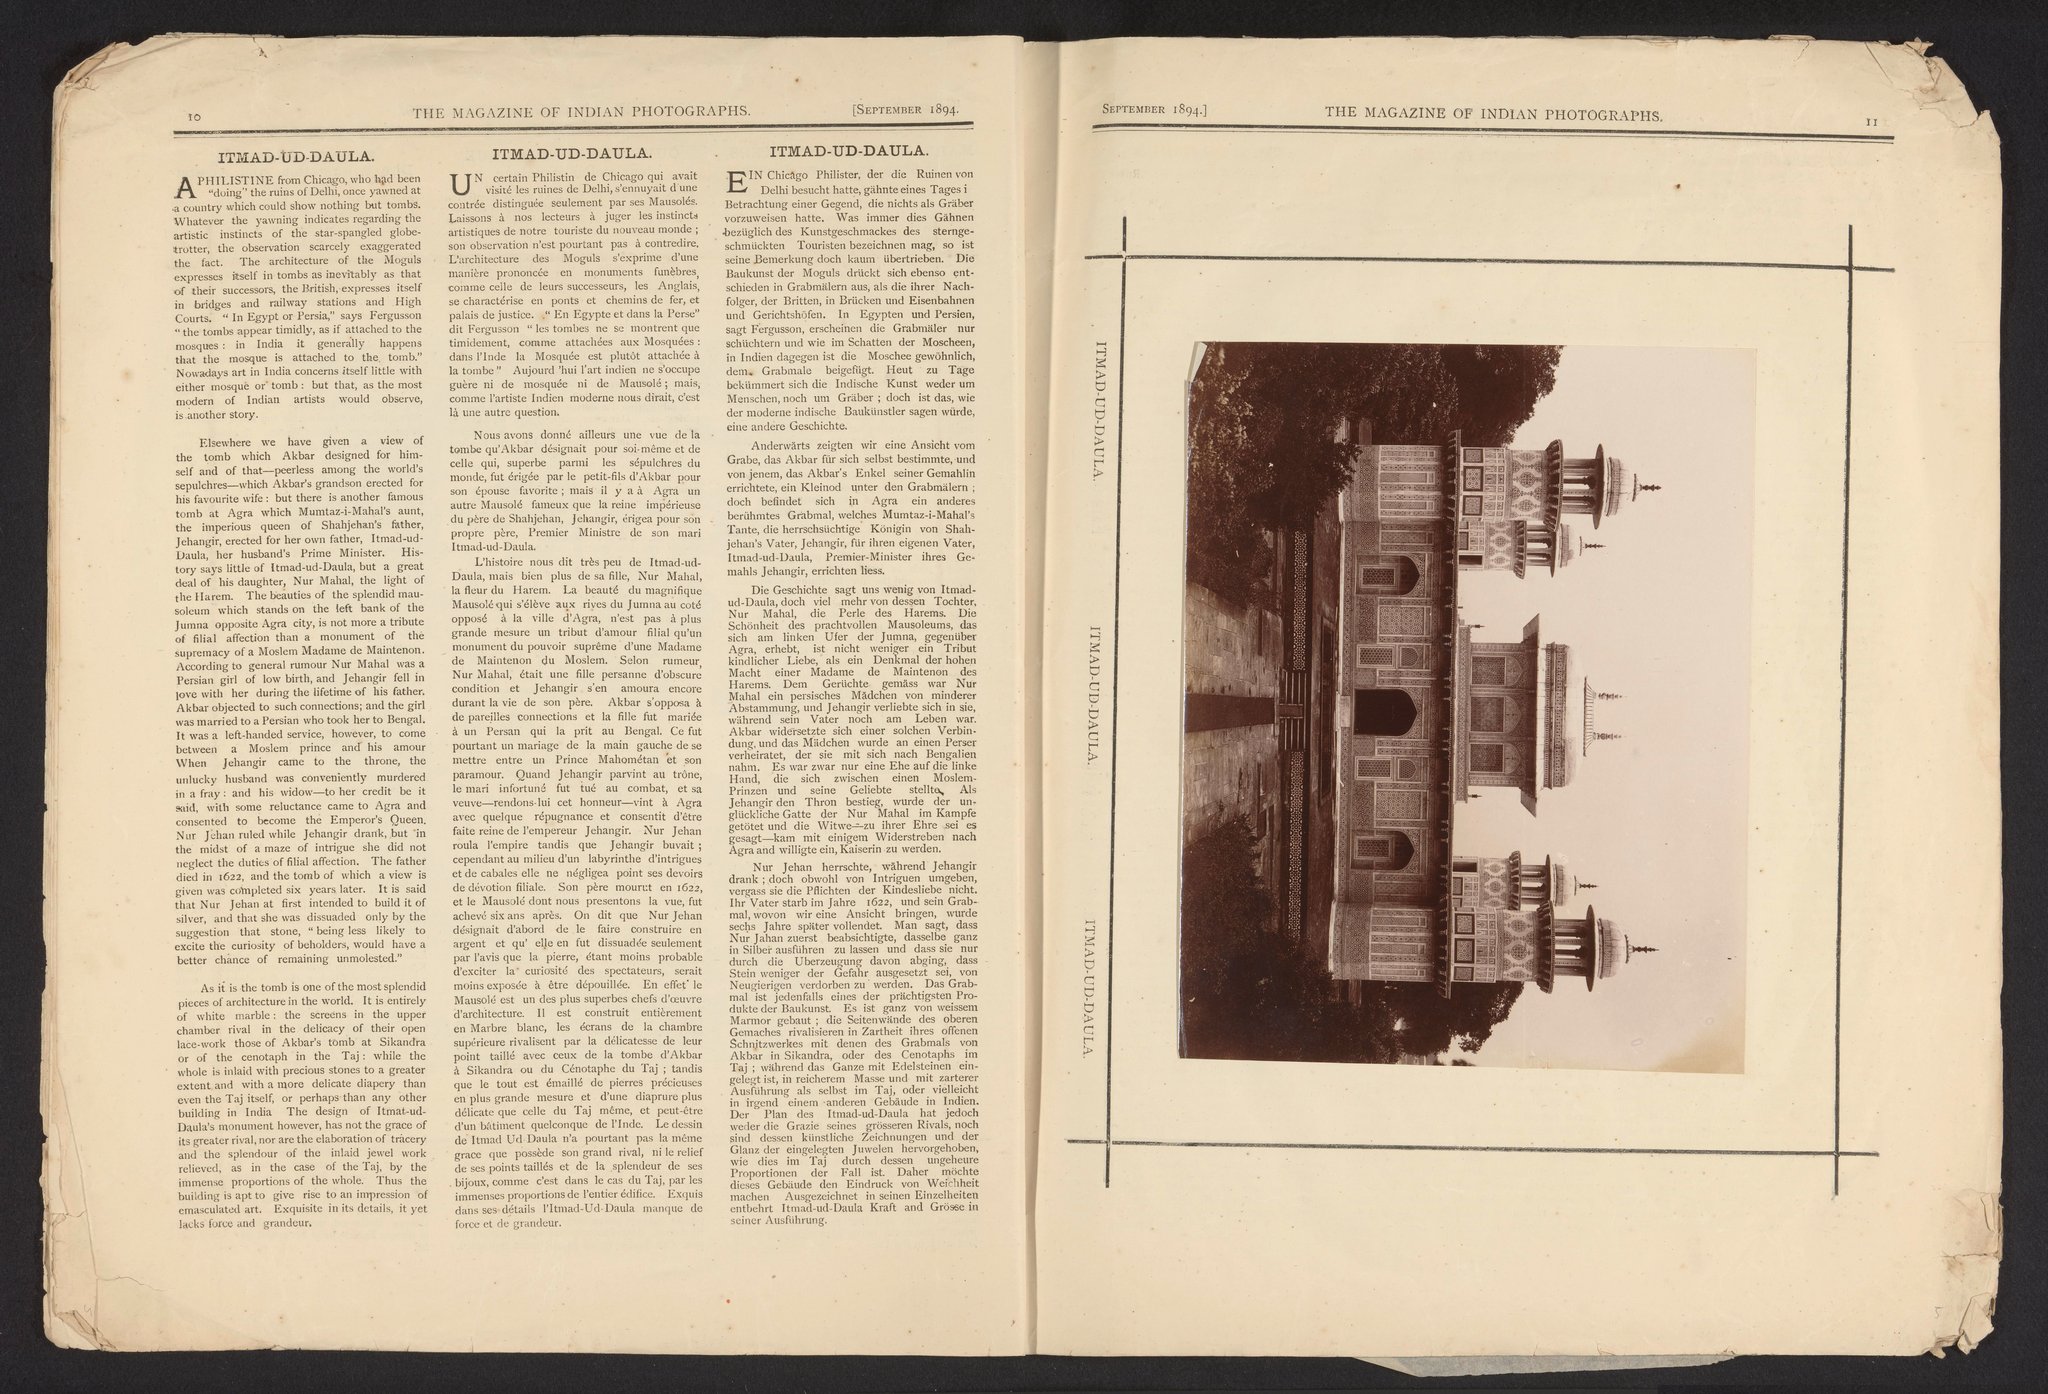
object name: photograph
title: Tomb of Itmad-Ud-Daulah at Agra, Uttar Pradesh, India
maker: Anonymous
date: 1889-1894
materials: photographic support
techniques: albumen print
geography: agra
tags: mausoleum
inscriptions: title: ‘ITMAD-UD-DAULA. ITMAD-UD-DAULA. ITMAD-DU-DAULA.’